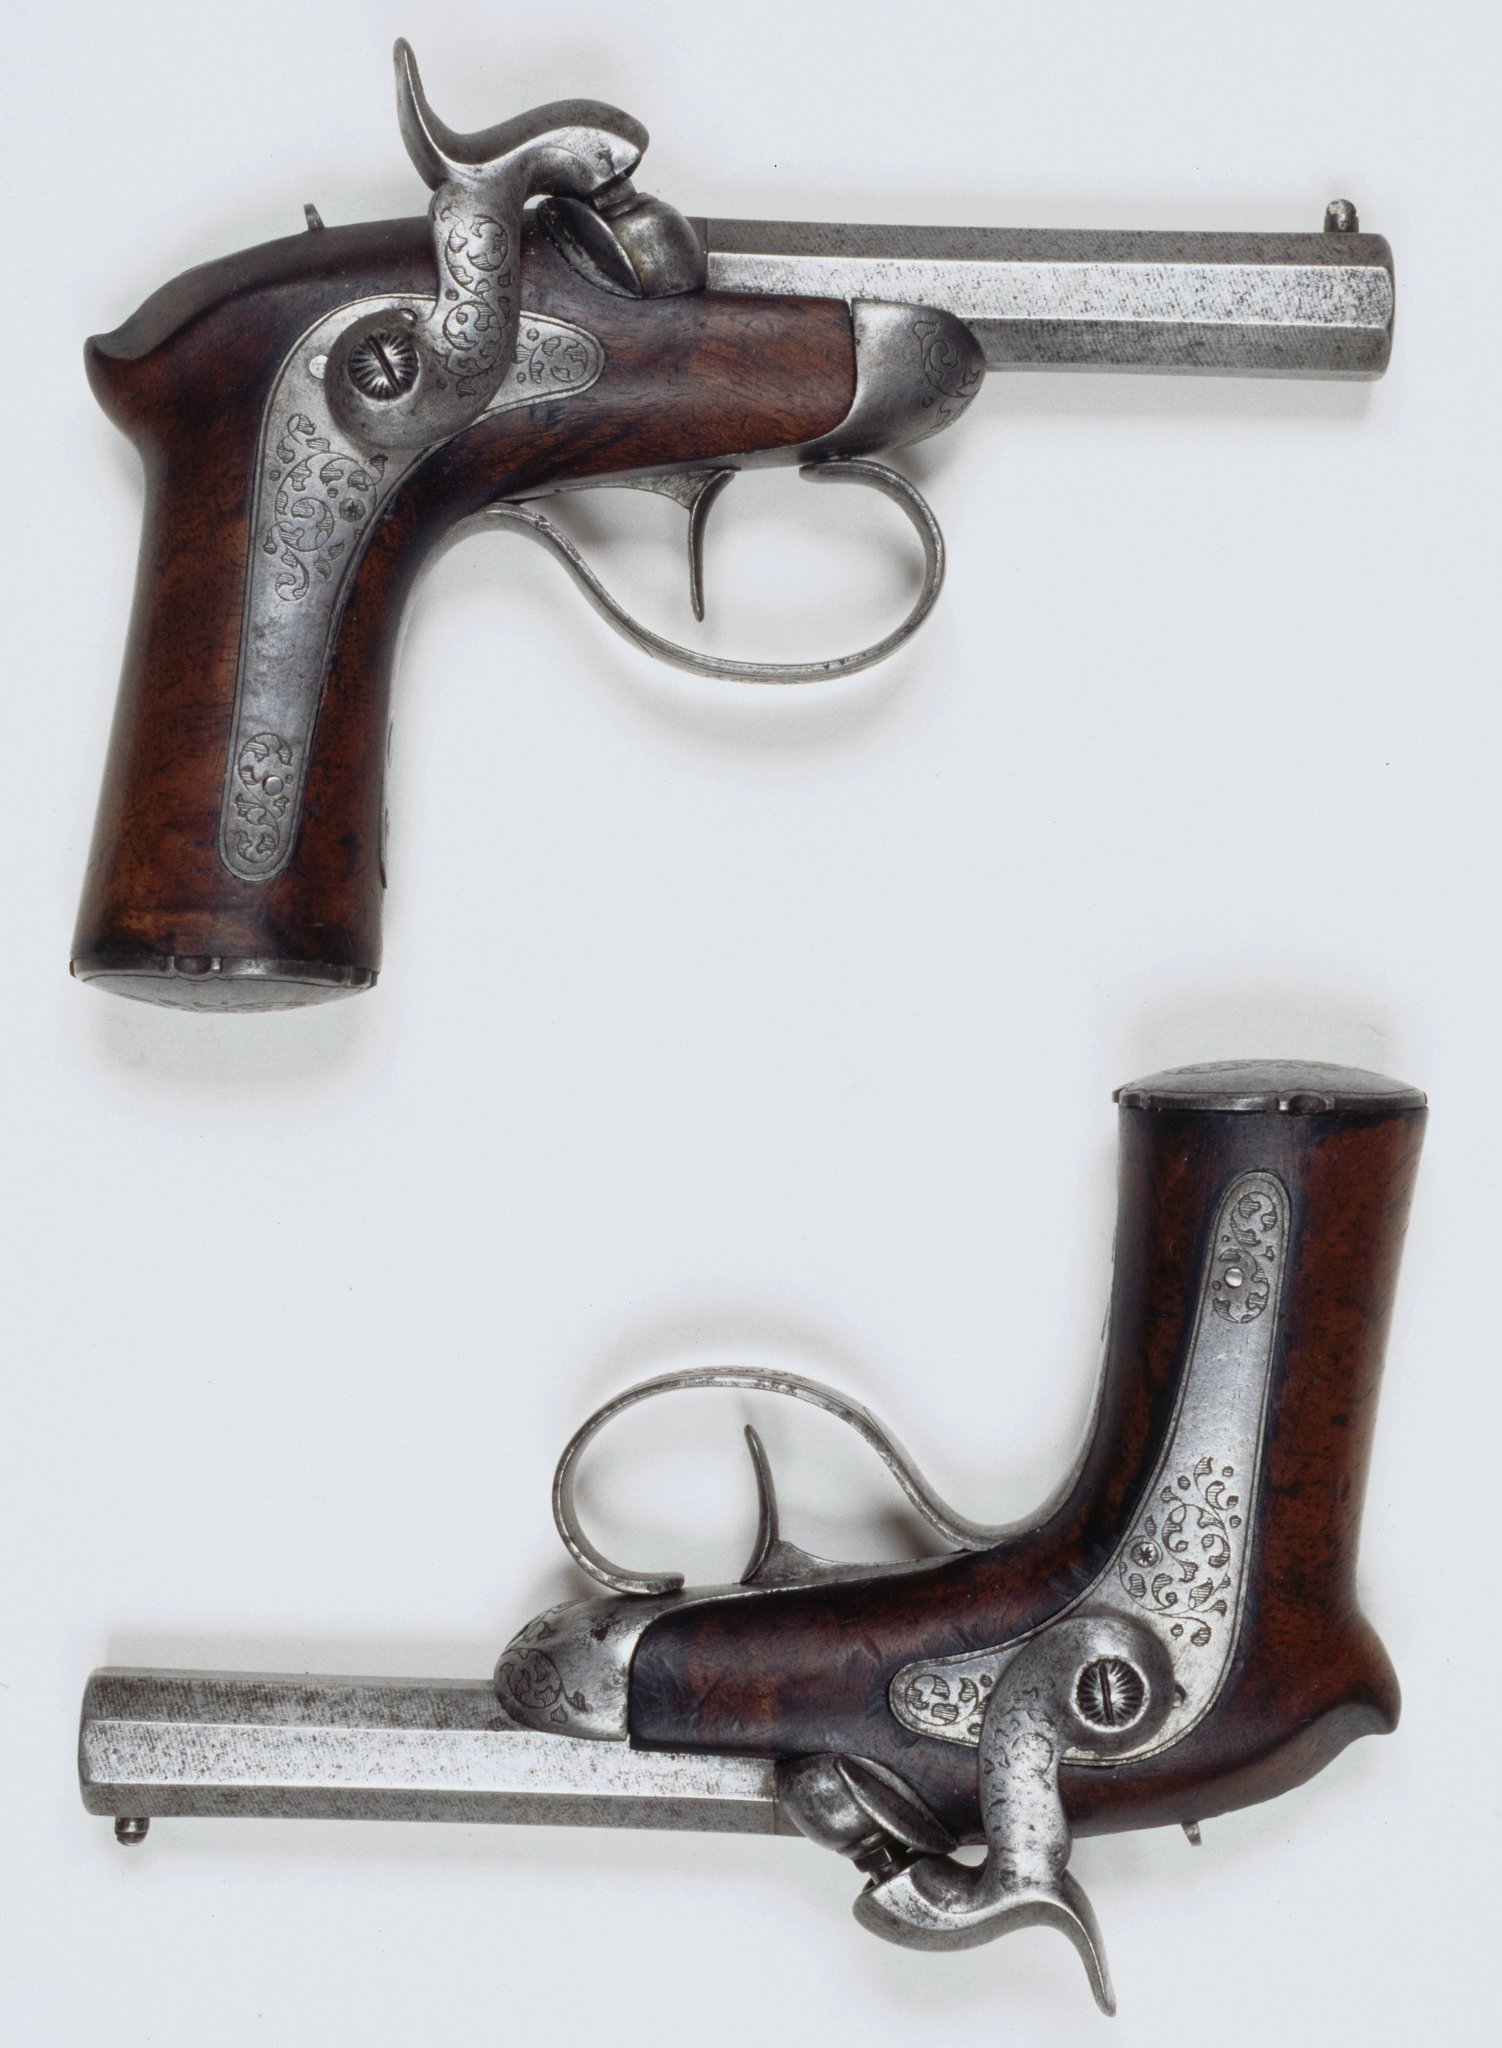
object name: pocket pistol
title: Zakpistool met percussieslot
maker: henri gustave delvigne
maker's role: geweermaker, pistoolmaker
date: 1814-1866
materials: iron, wood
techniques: engraving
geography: western europe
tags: netherlands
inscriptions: mark: ‘INVon DELVIGNE’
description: Zakpistool met percussieslot, deel van koppel, ijzer met hout, achthoekige ijzeren loop met houten kolf waarvan de kolfkap van ijzer is met gegraveerd lofwerk. Het slot is in het pistool ingebouwd. De haan is van ijzer en is aan de zijkant gegraveerd met enig lofwerk. Beugel is aan de onderzijde met lofwerk gegraveerd. IJzeren vizierkorrel. Aan de bovenzijde van de loop van de naam van de vervaardiger INVon DELVIGNE.